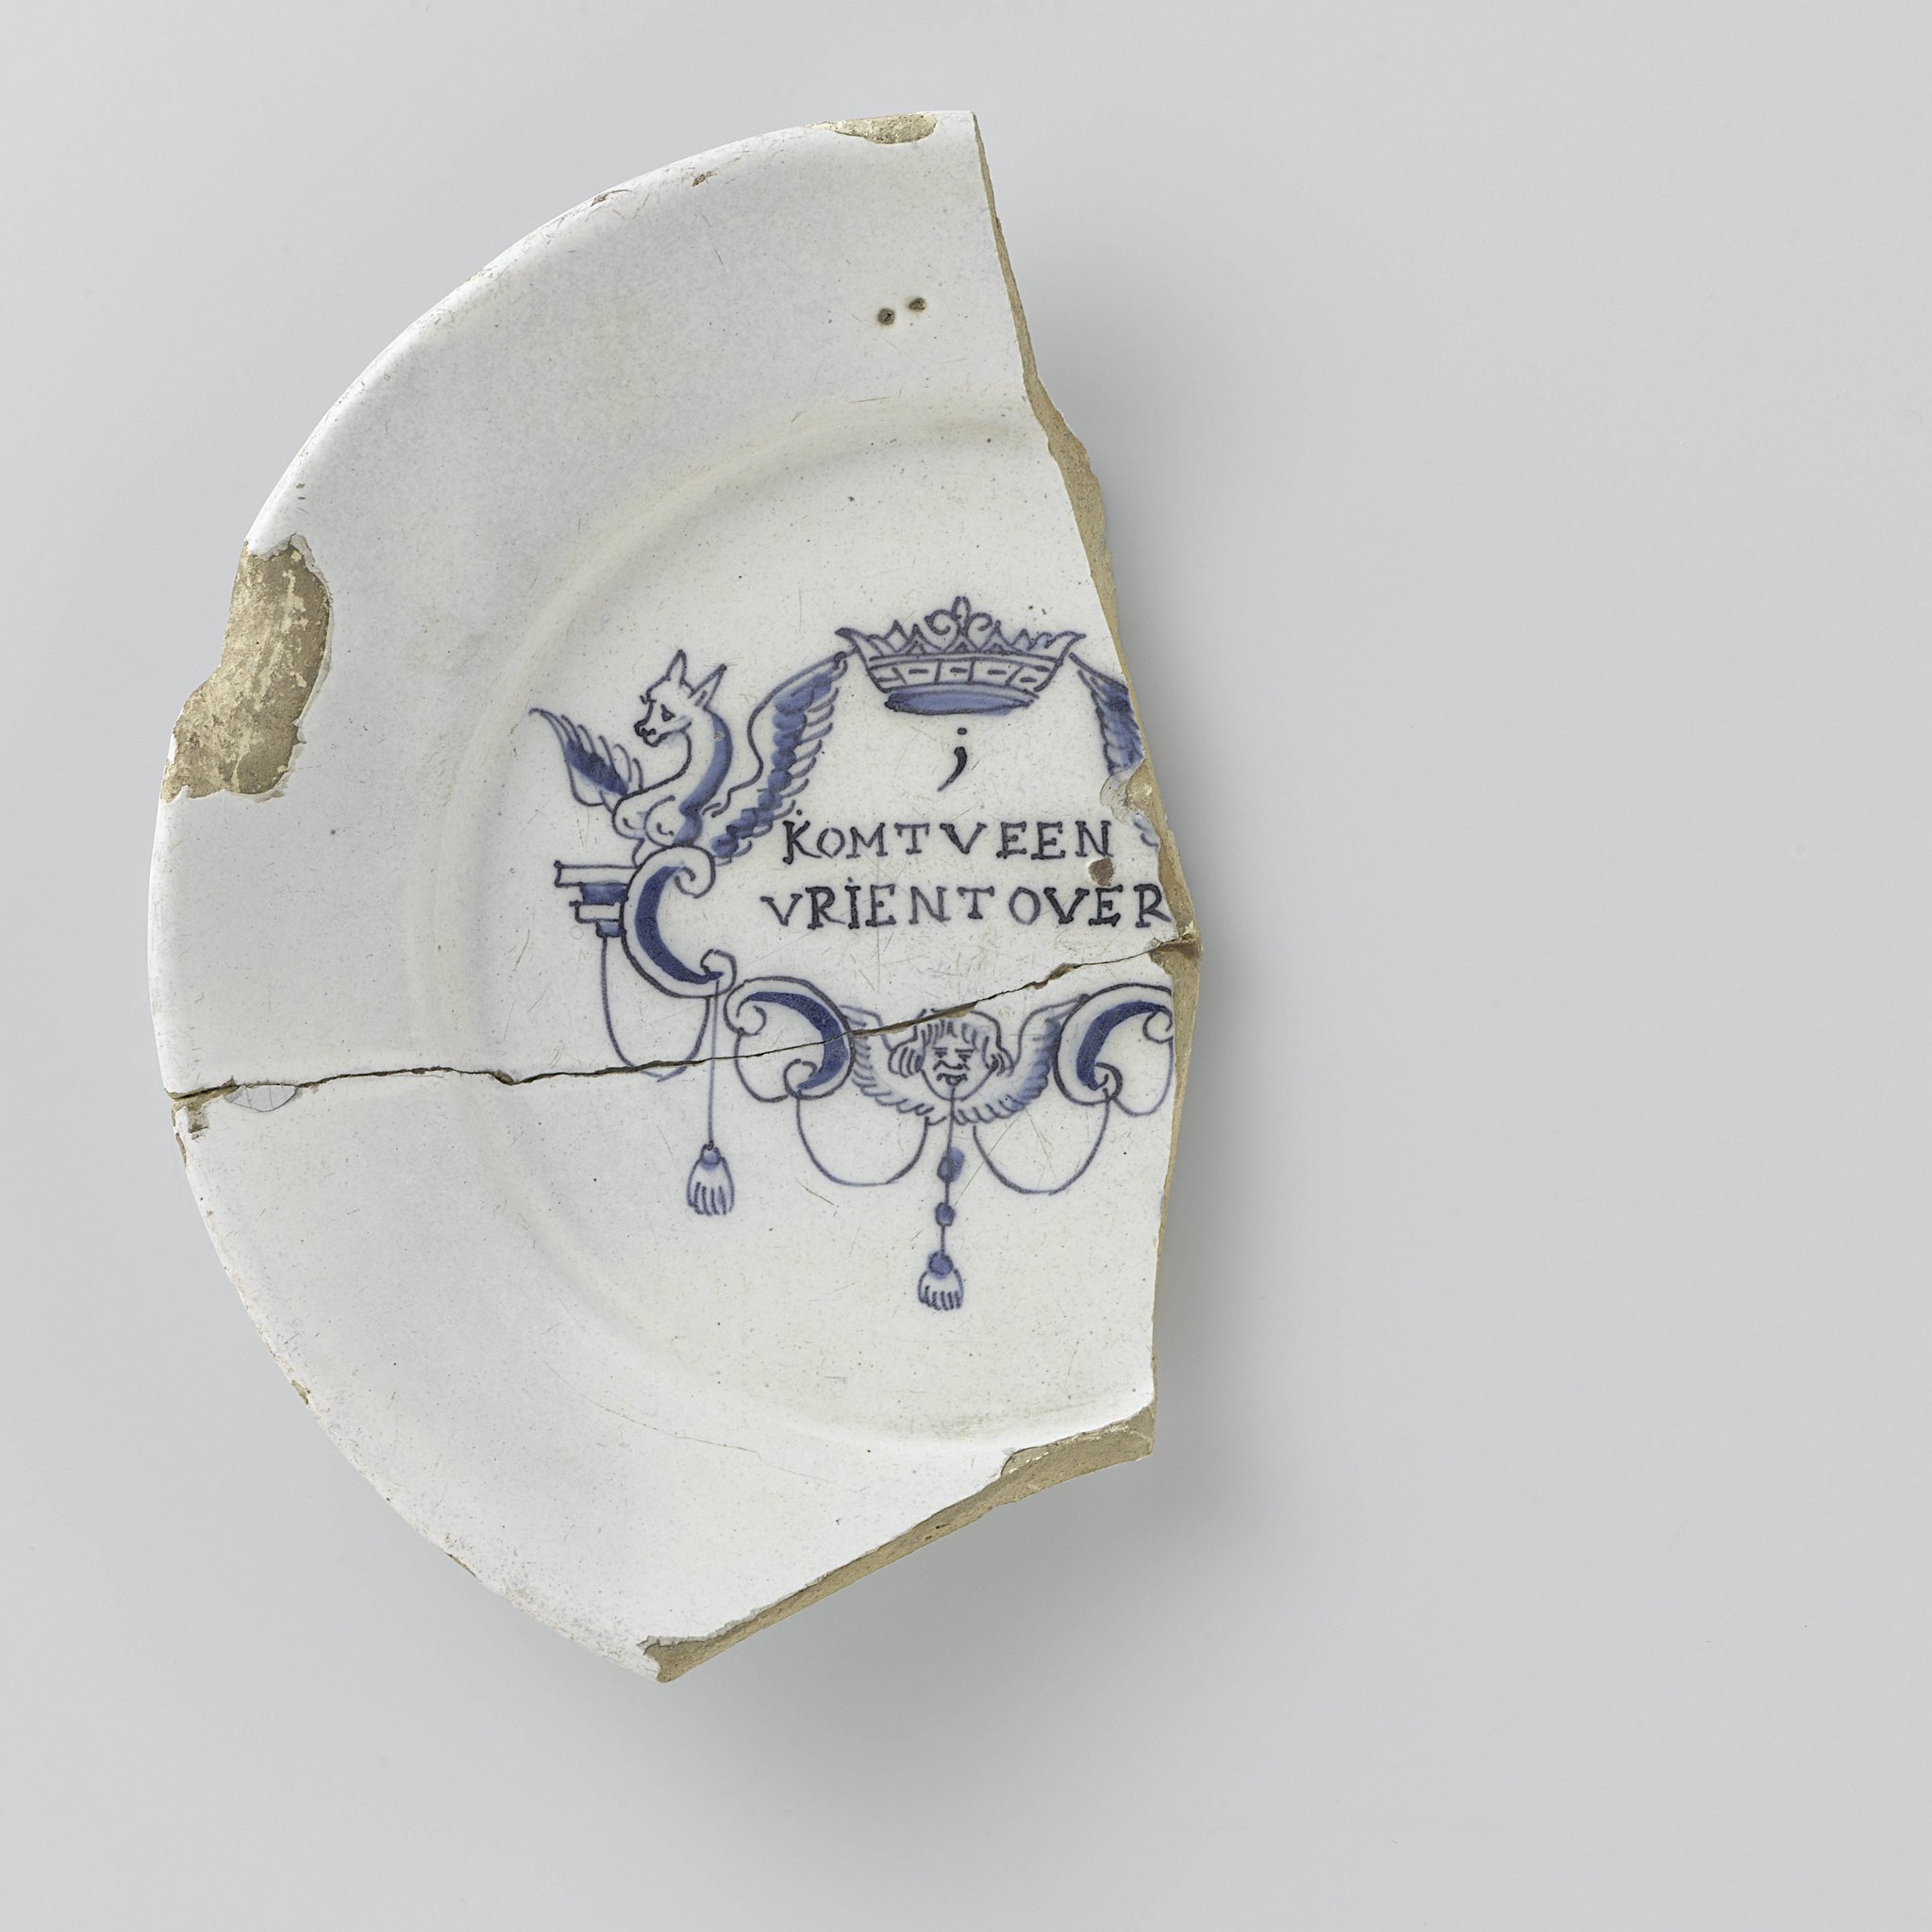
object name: plate dish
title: Fragment van een bord, beschilderd in blauw onder het glazuur met een cartouche, waarin de tekst: i // KOMT V EEN // VRIENT OVER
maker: Anonymous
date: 1600-1650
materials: earthenware, glaze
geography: northern netherlands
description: Fragment van een bord van aardewerk, beschilderd in blauw onder het glazuur met een cartouche, waarin de tekst: i // KOMT V EEN // VRIENT OVER.